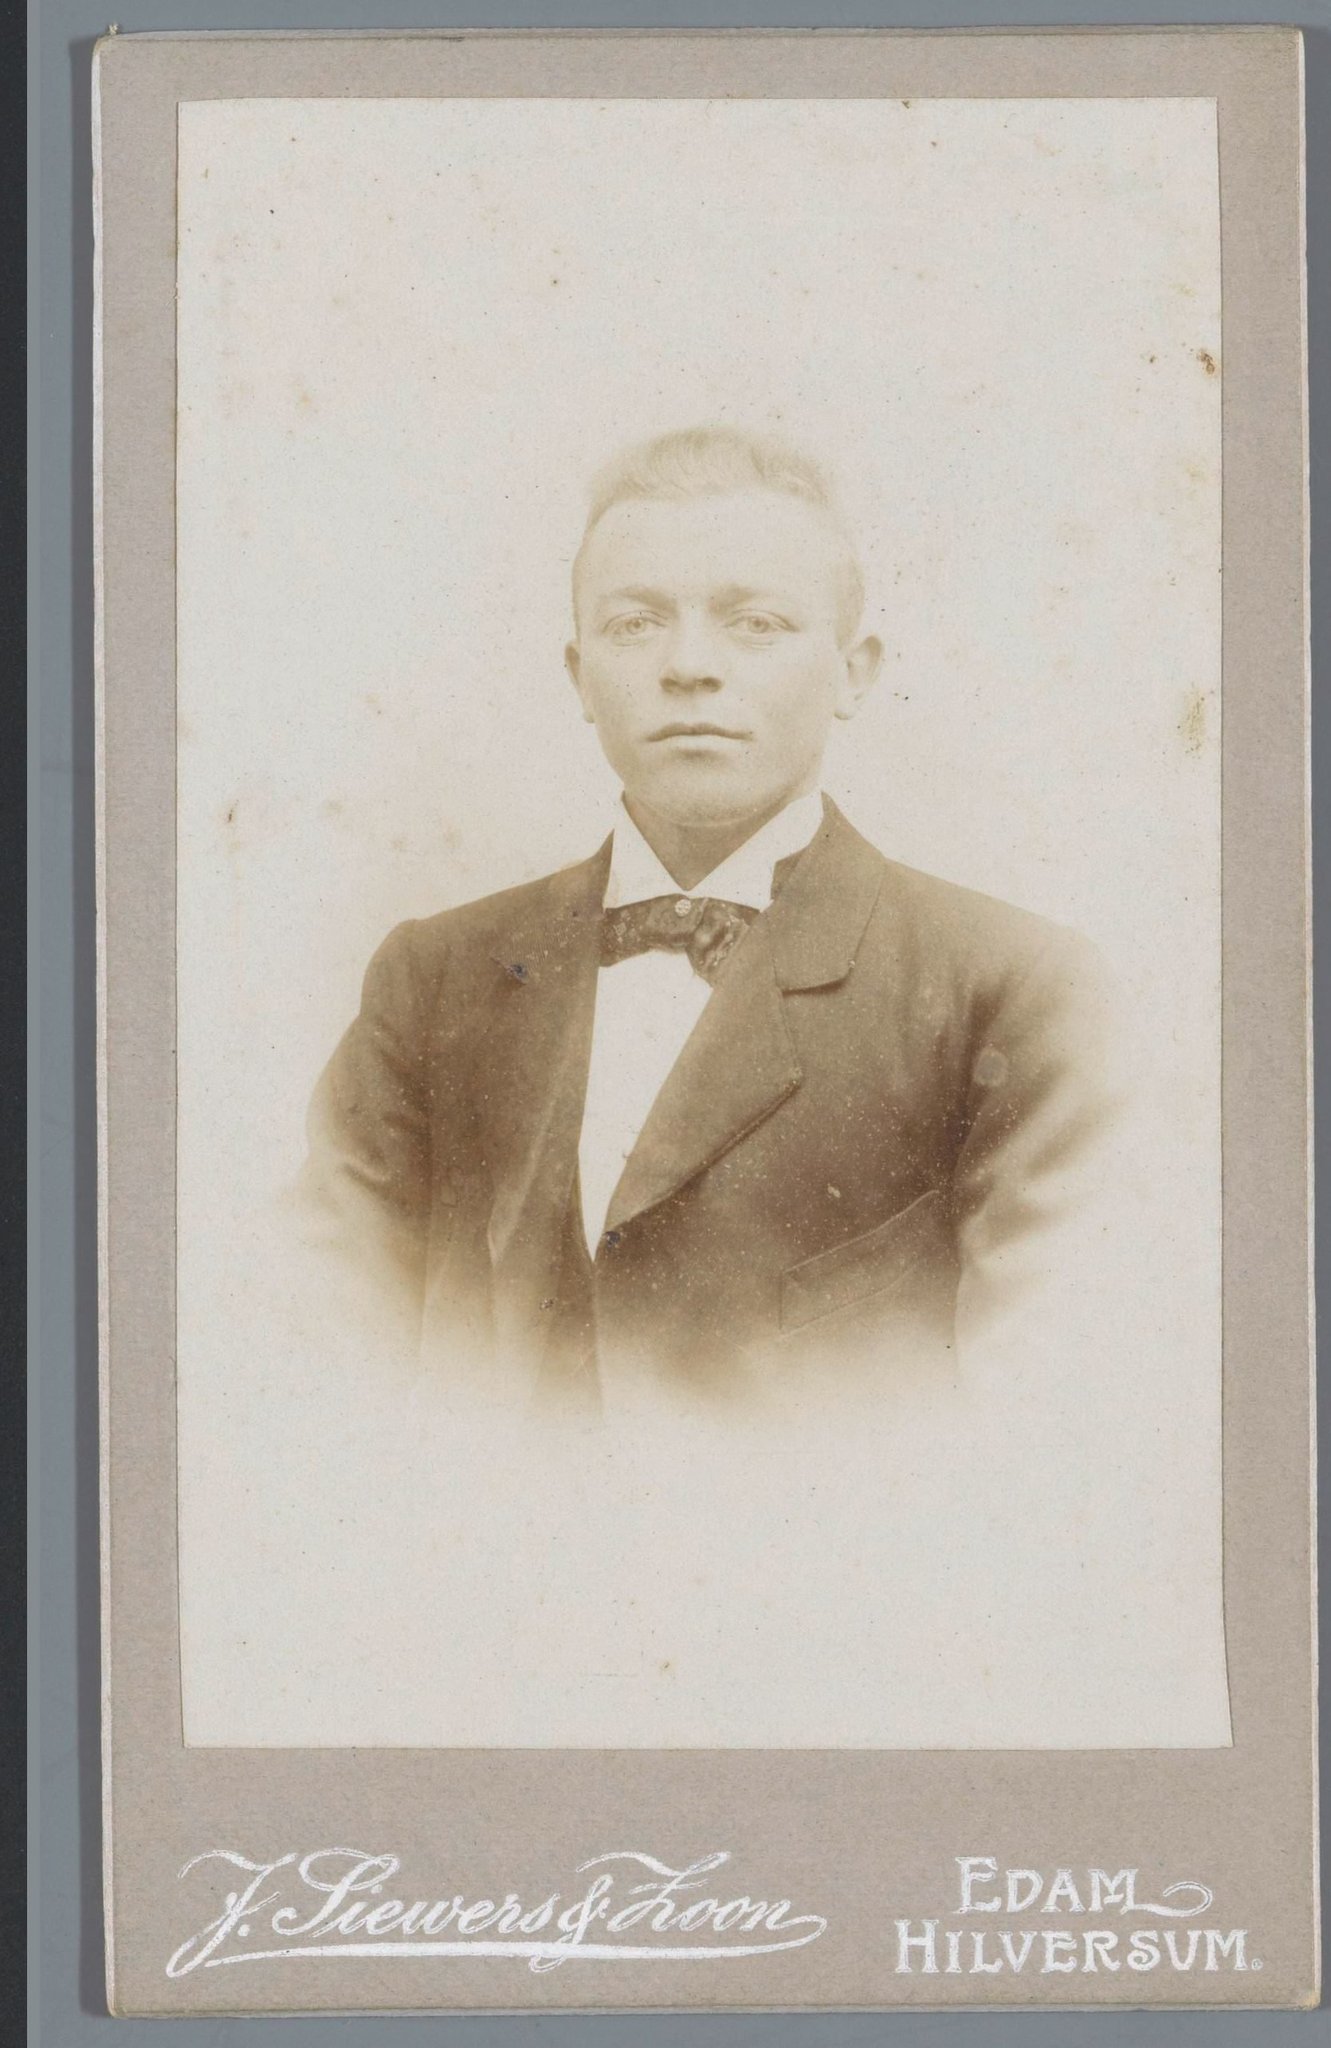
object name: carte de visite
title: Portret van een onbekende man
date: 1890-1918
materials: cardboard, photographic support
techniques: collodion silver print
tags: adult man, historical persons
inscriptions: inscription: ‘Photographische/ ATELIERS/ J. Siewers & Zoon/ EDAM/ HILVERSUM./ Specialiteit in vergrootingen.’